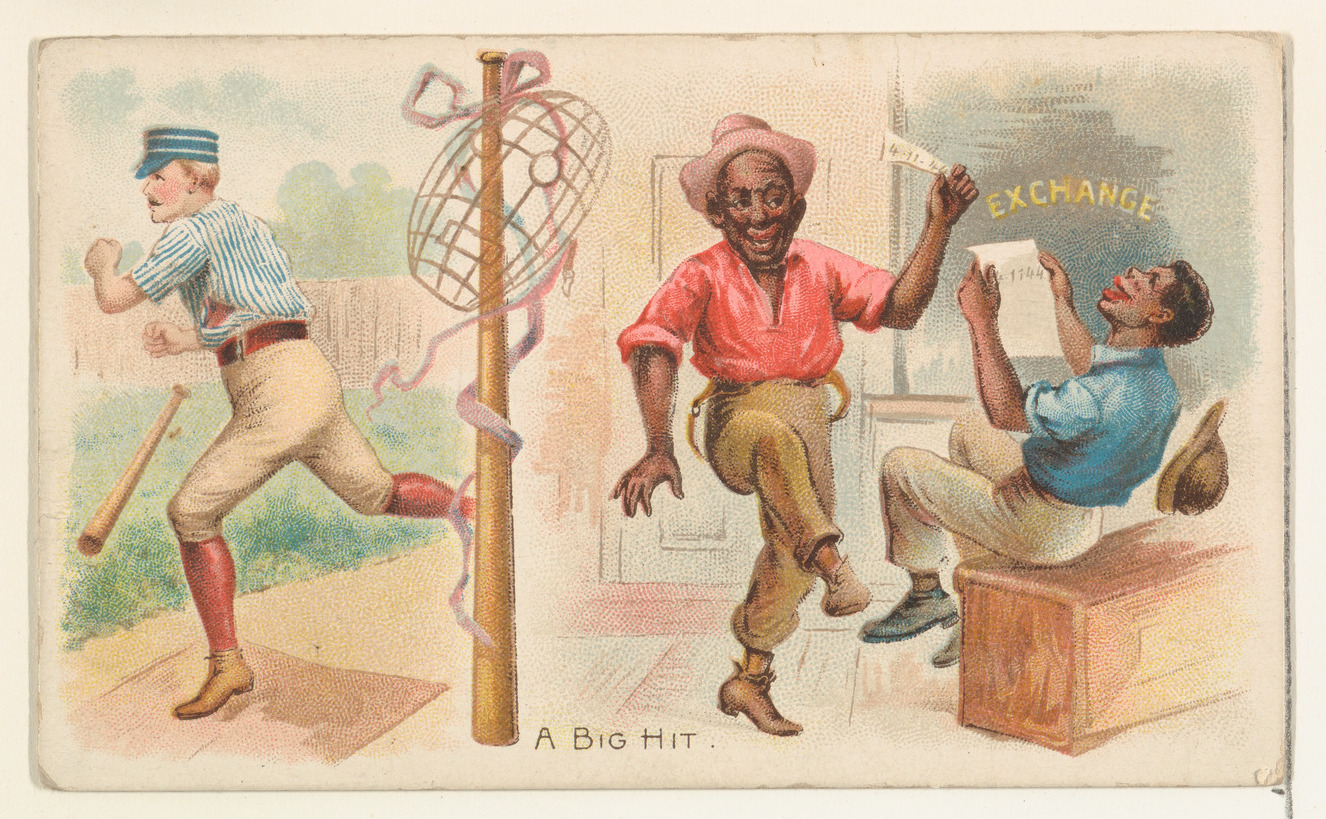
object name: print, baseball card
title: A Big Hit, from the Talk of the Diamond set (N135) issued by Duke Sons & Co., a branch of the American Tobacco Company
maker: w. duke, sons & co.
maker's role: publisher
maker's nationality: american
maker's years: 1870-1920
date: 1888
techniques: color lithograph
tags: men